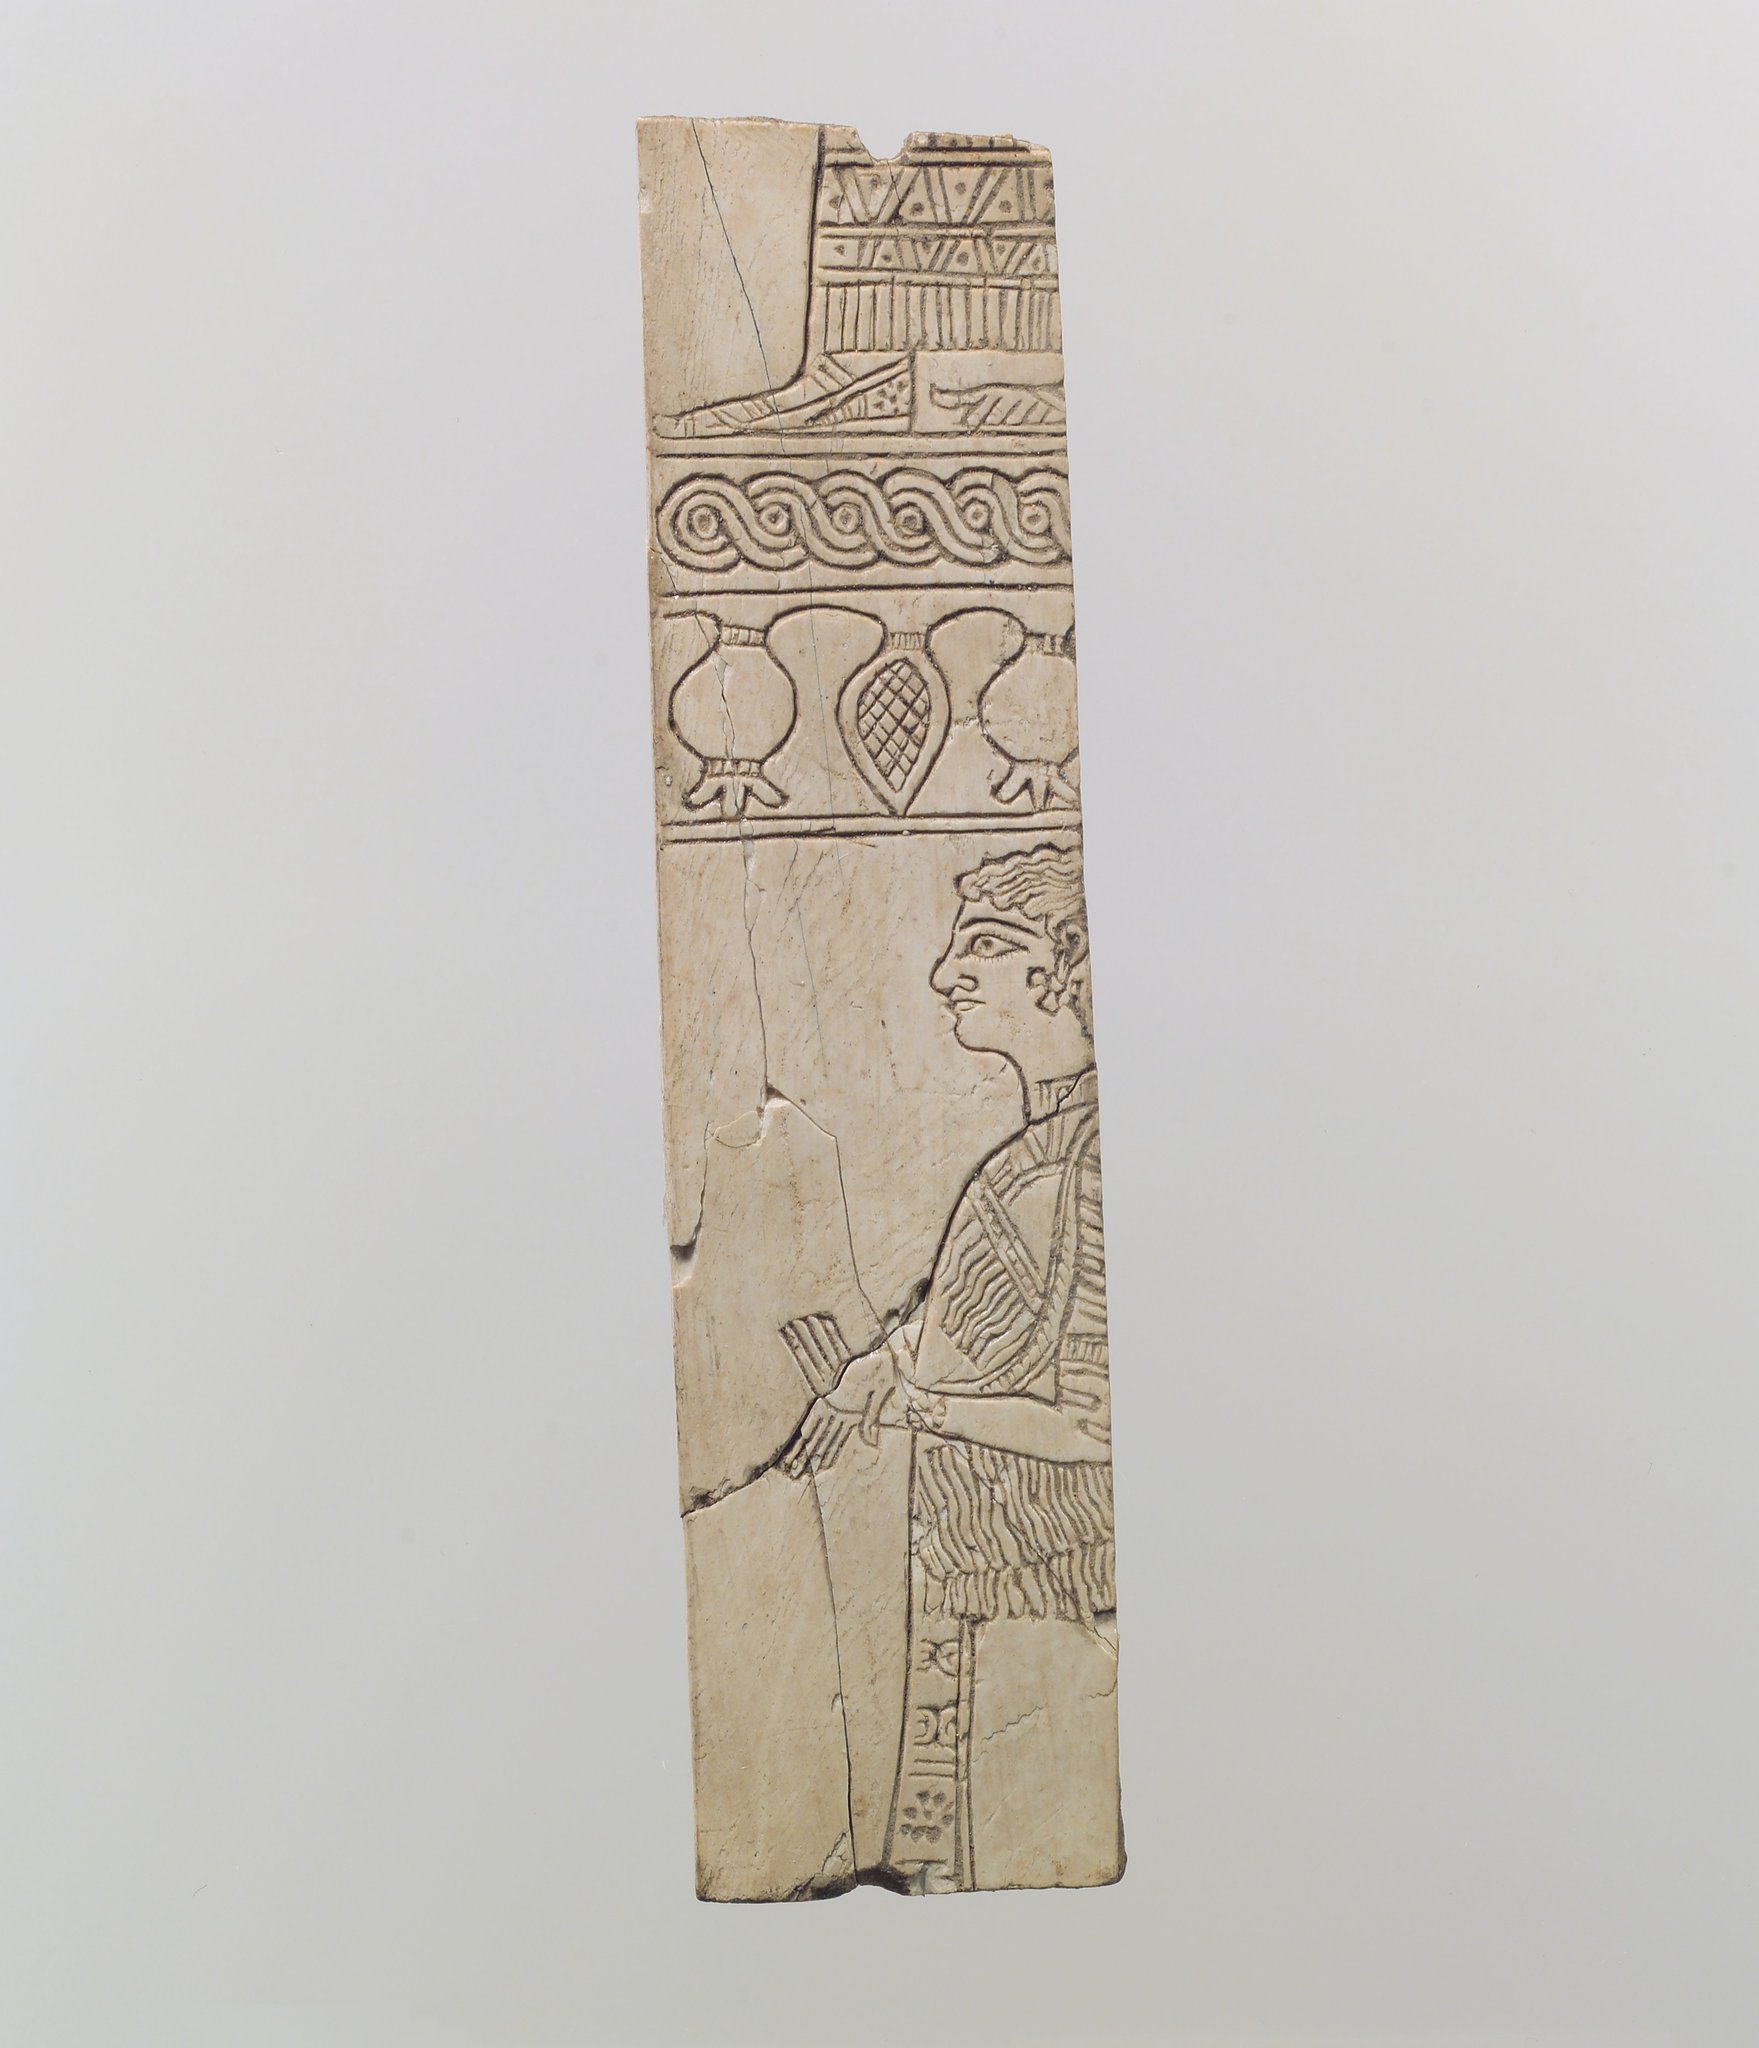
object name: relief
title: Incised furniture plaque with two figures in two registers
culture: assyrian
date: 900-801 BCE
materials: ivory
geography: mesopotamia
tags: men